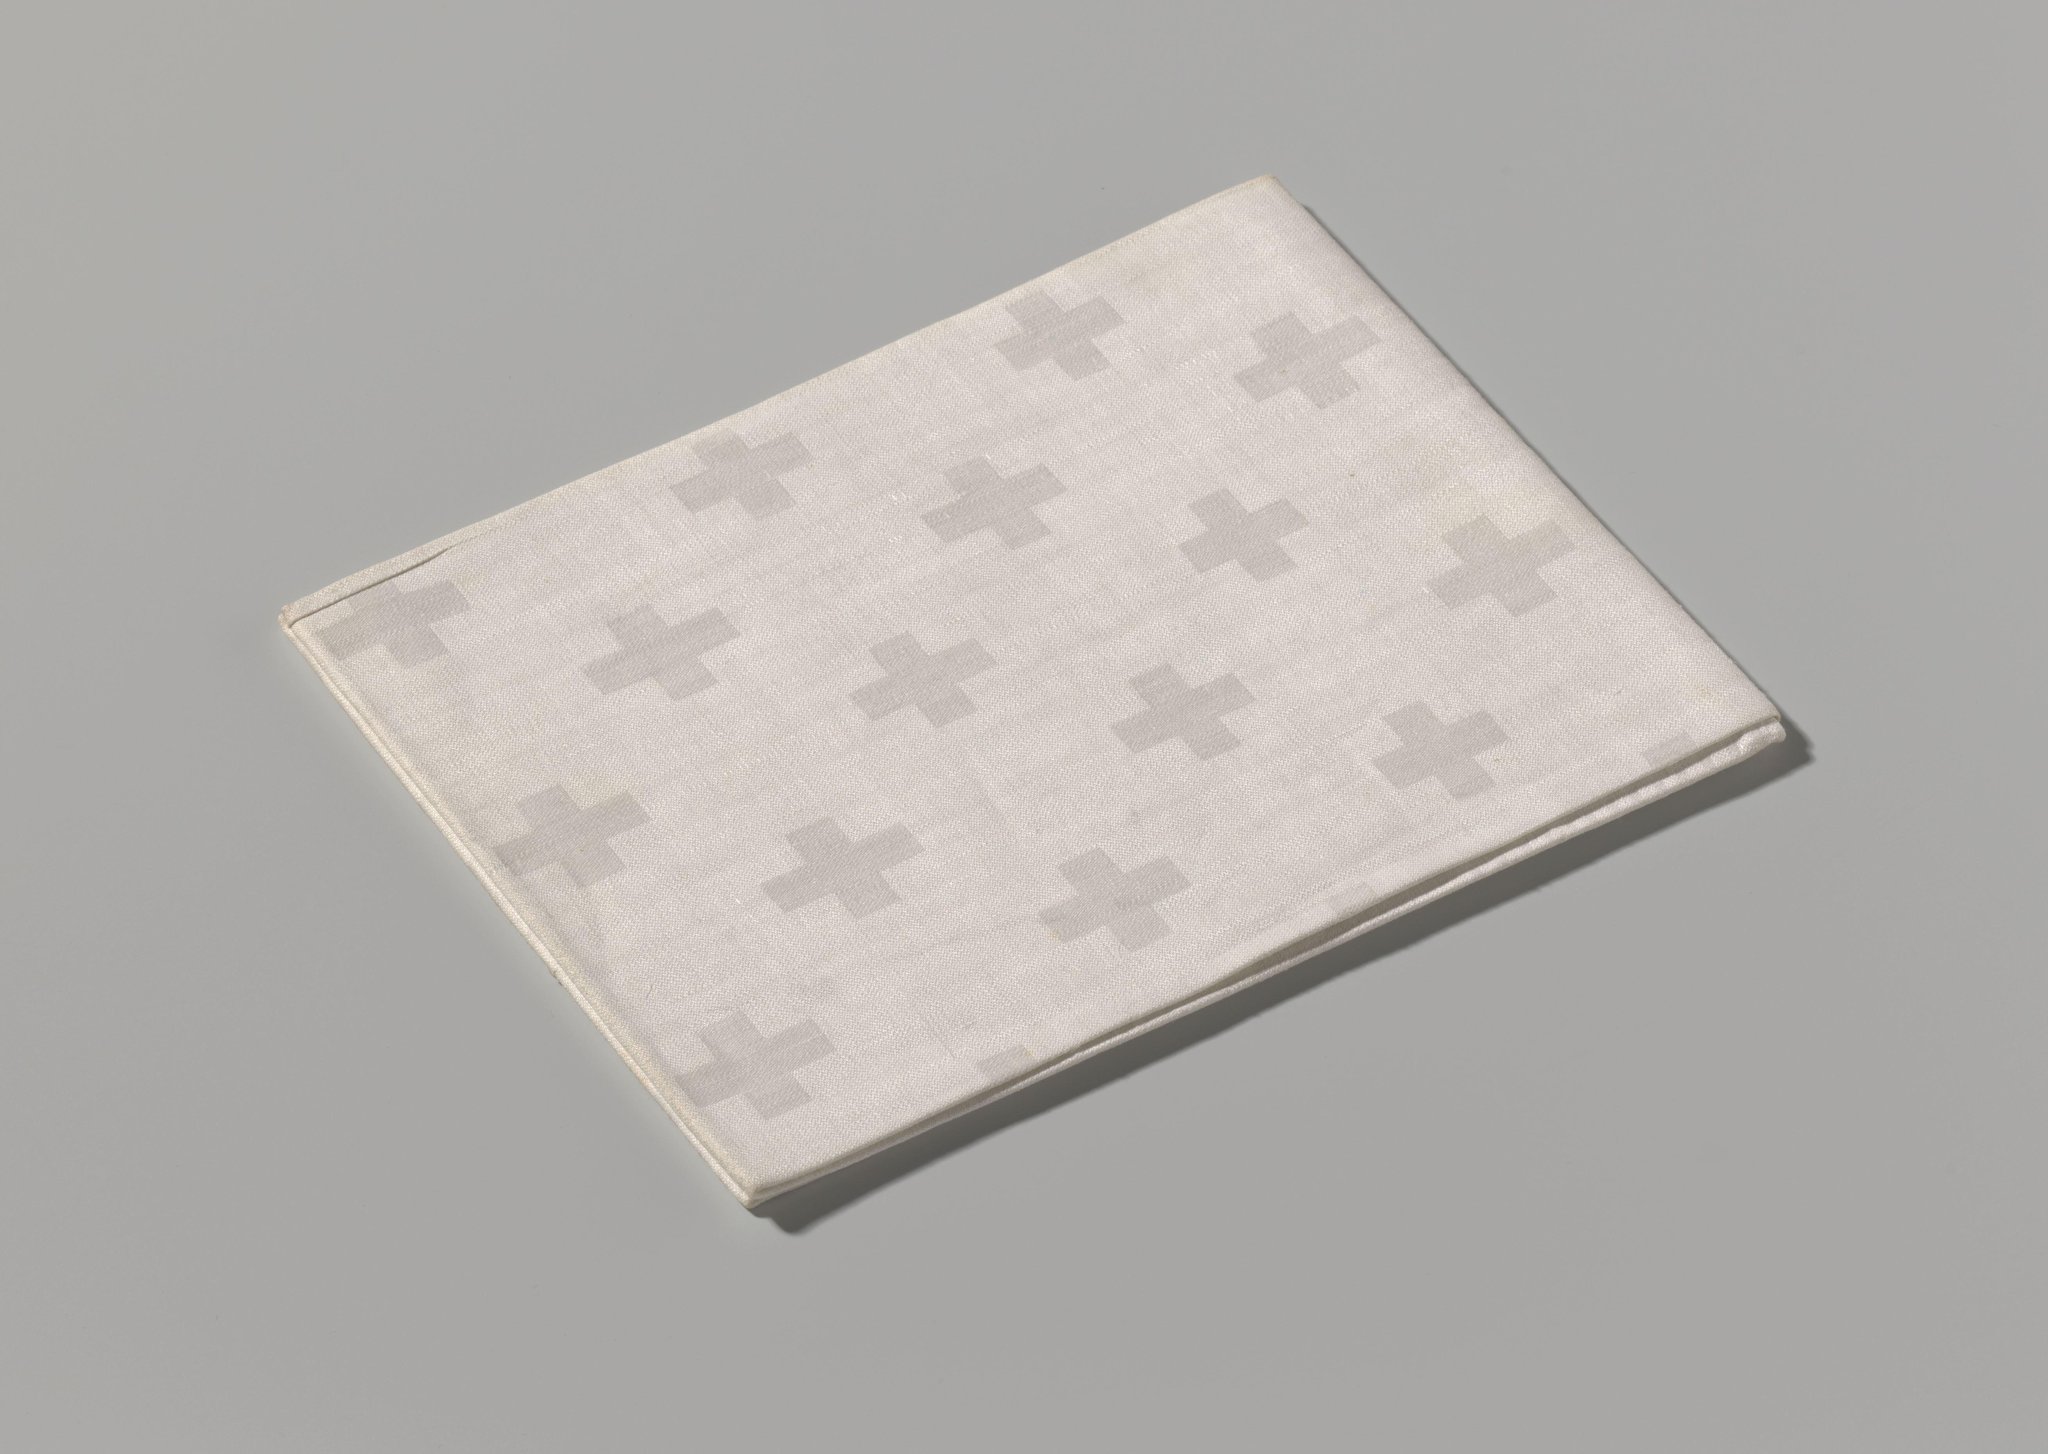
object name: napkin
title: Servet van linnen met pellenpatroon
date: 1870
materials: linen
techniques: peeled fabric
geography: northern netherlands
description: wit linnen servet met pellen patroon, merk HW 24 en 1870